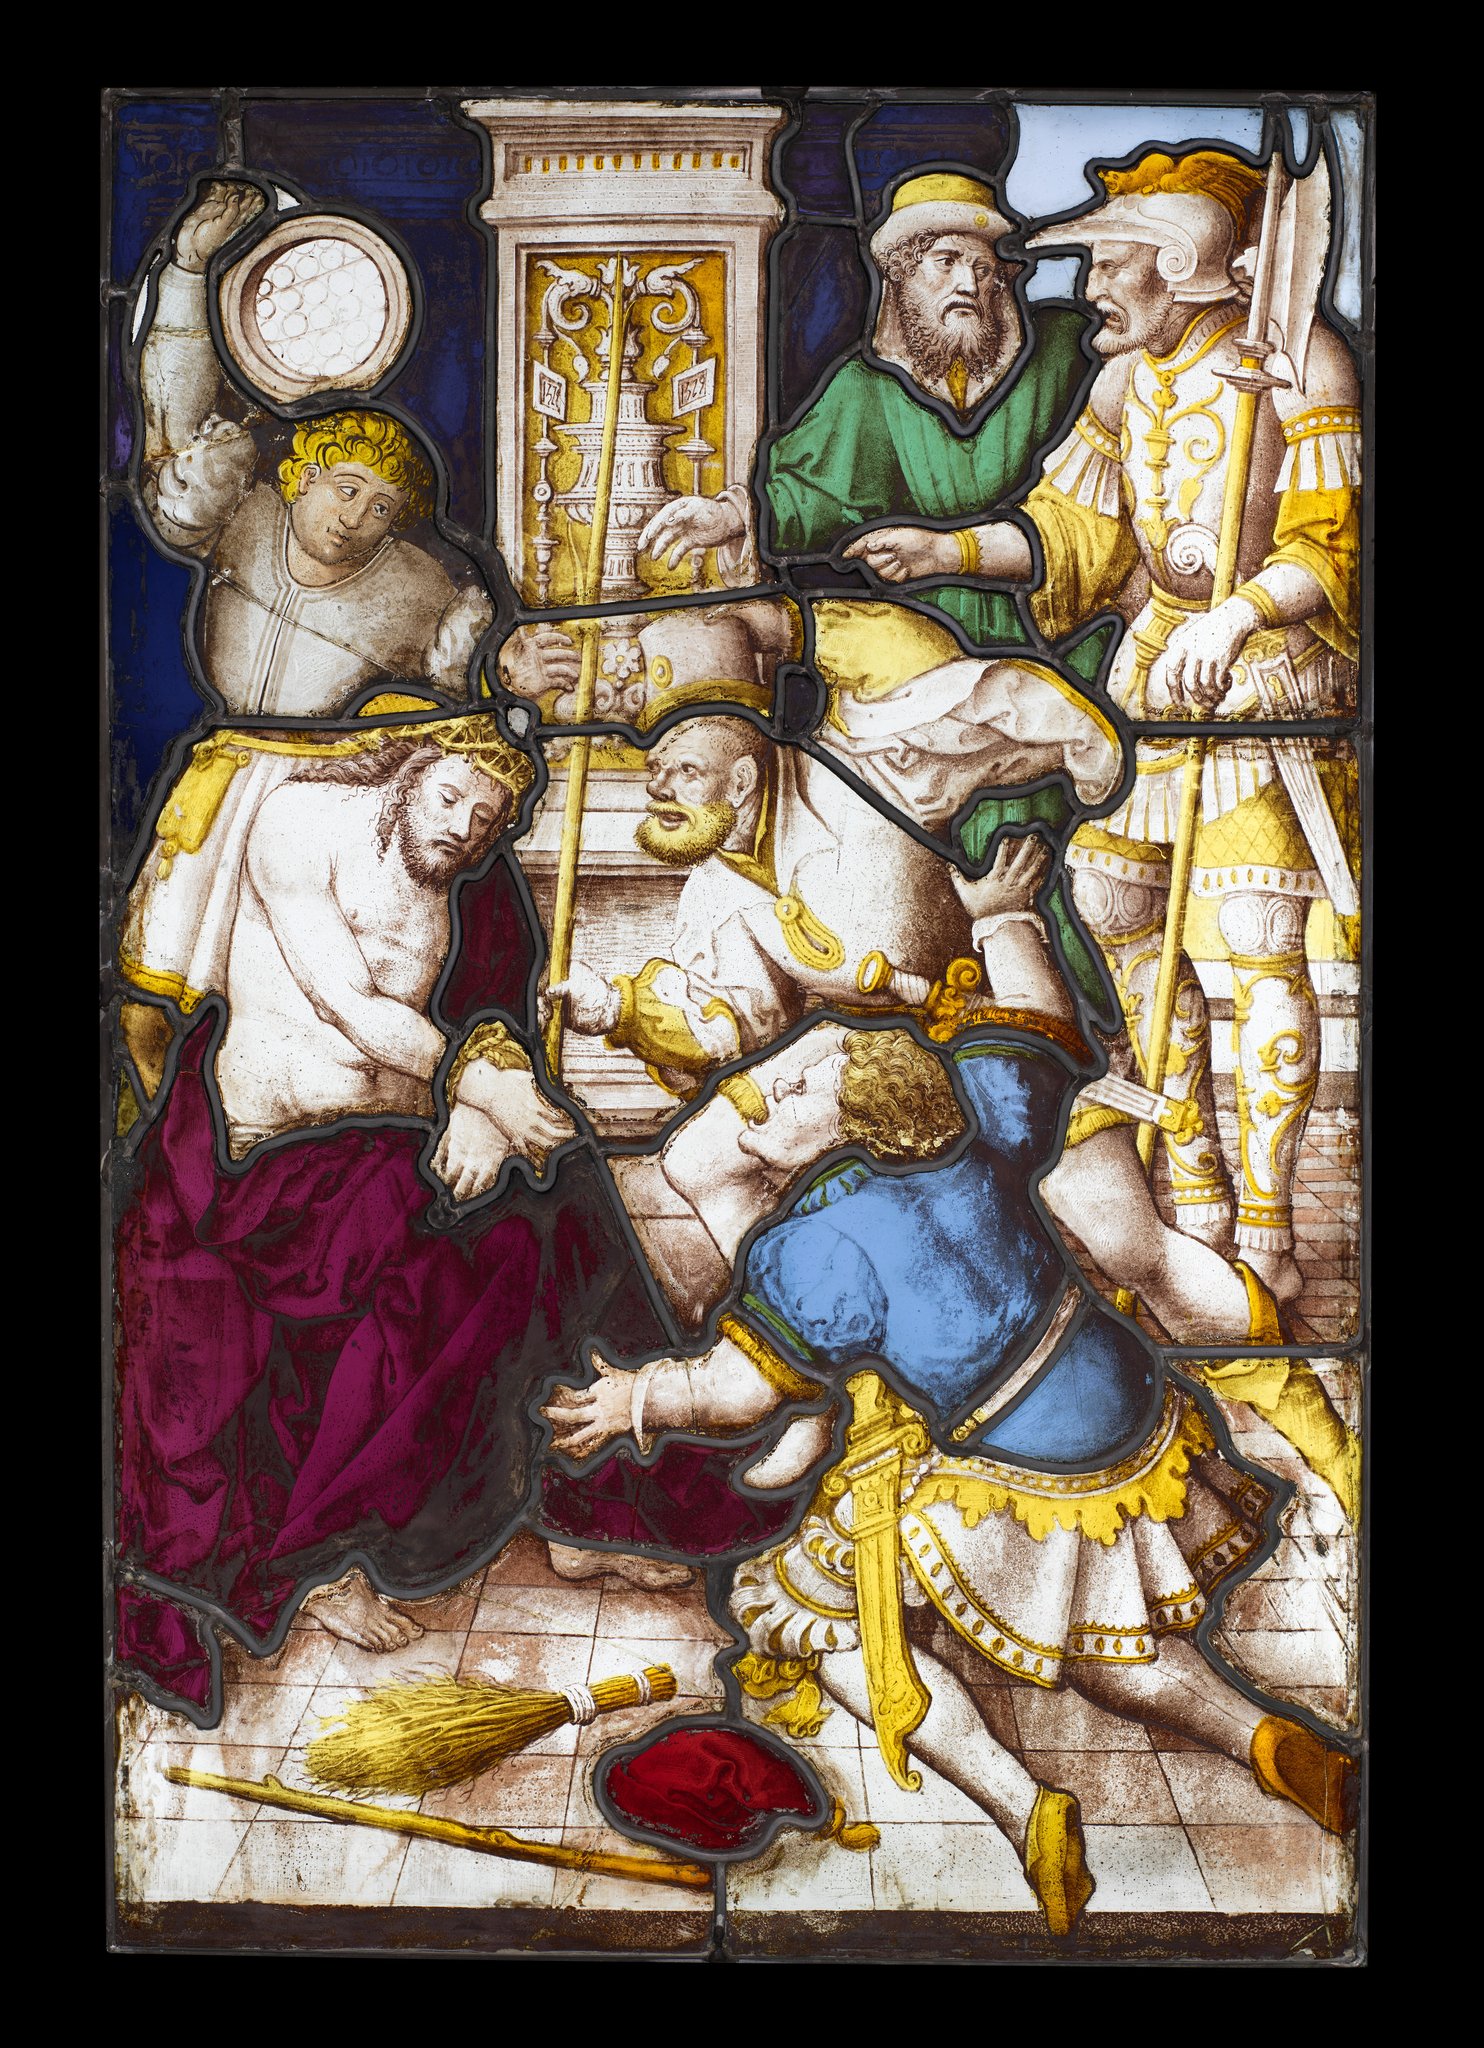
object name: panel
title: The Mocking of Christ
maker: jan rombouts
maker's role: maker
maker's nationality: south netherlandish (duchy of brabant)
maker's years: 1475-1535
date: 1529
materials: glass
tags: soldiers,men,christ